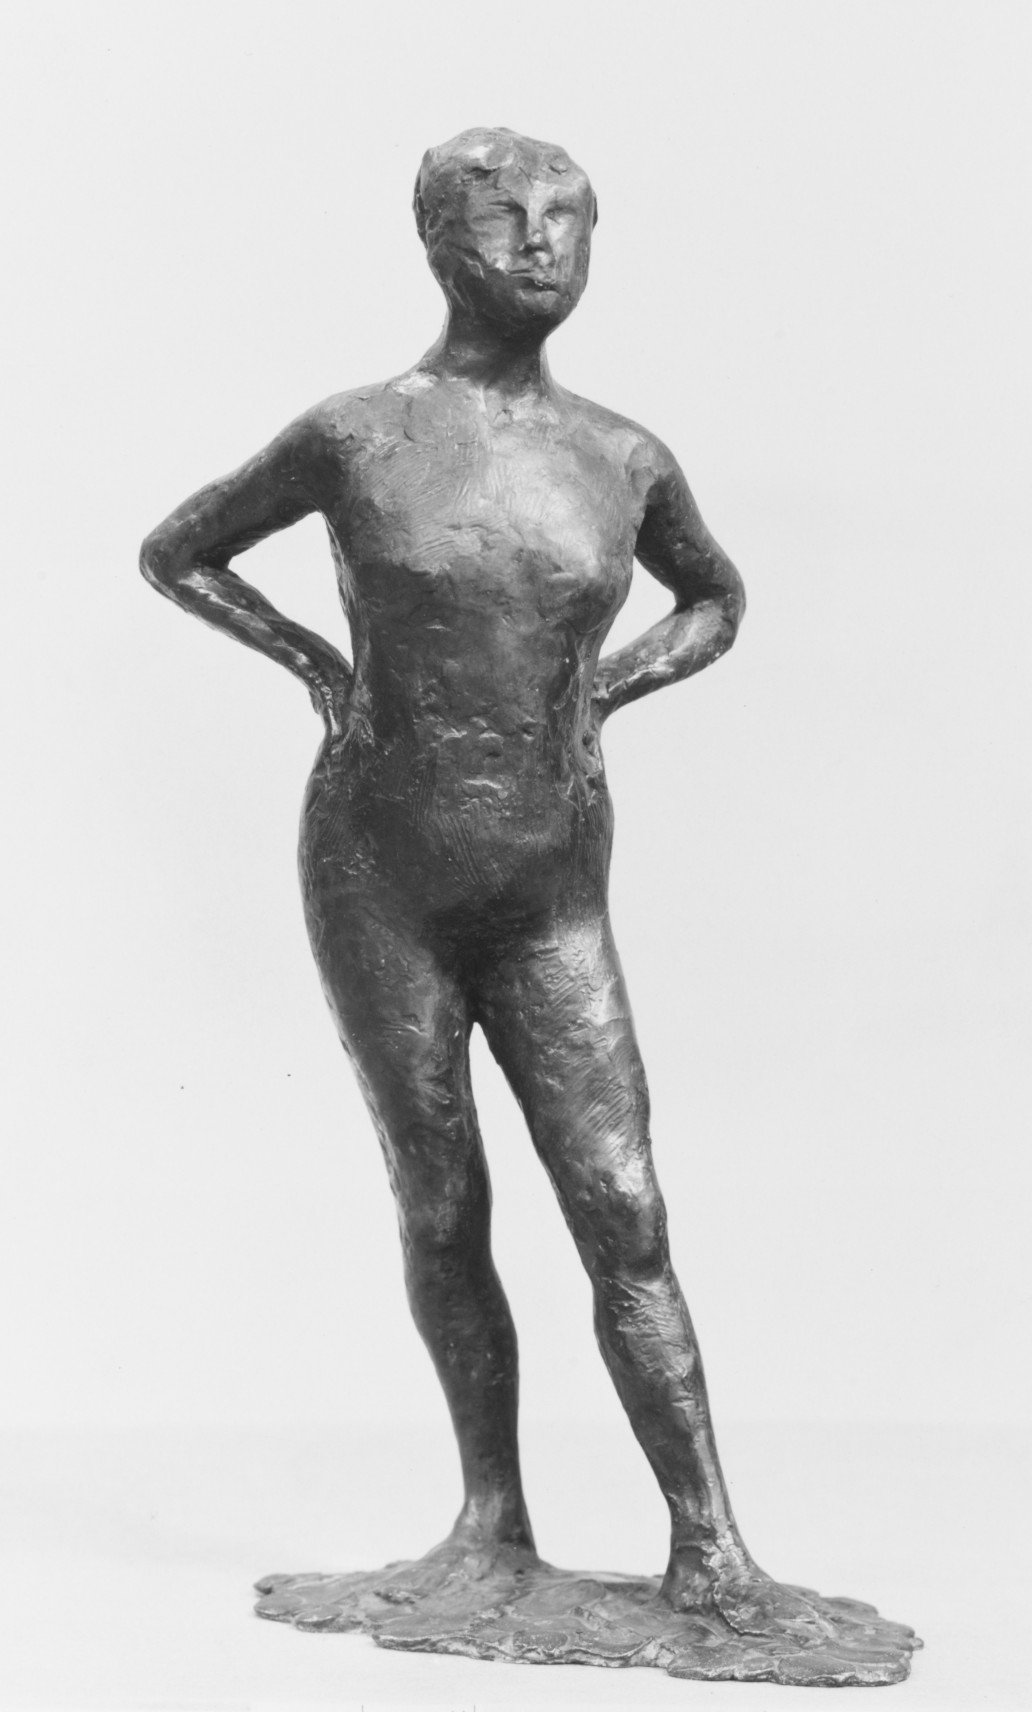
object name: statuette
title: Dancer at Rest, Hands on Her Hips, Left Leg Forward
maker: edgar degas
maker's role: artist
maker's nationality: french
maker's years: 1834-1917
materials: bronze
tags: women,dancers